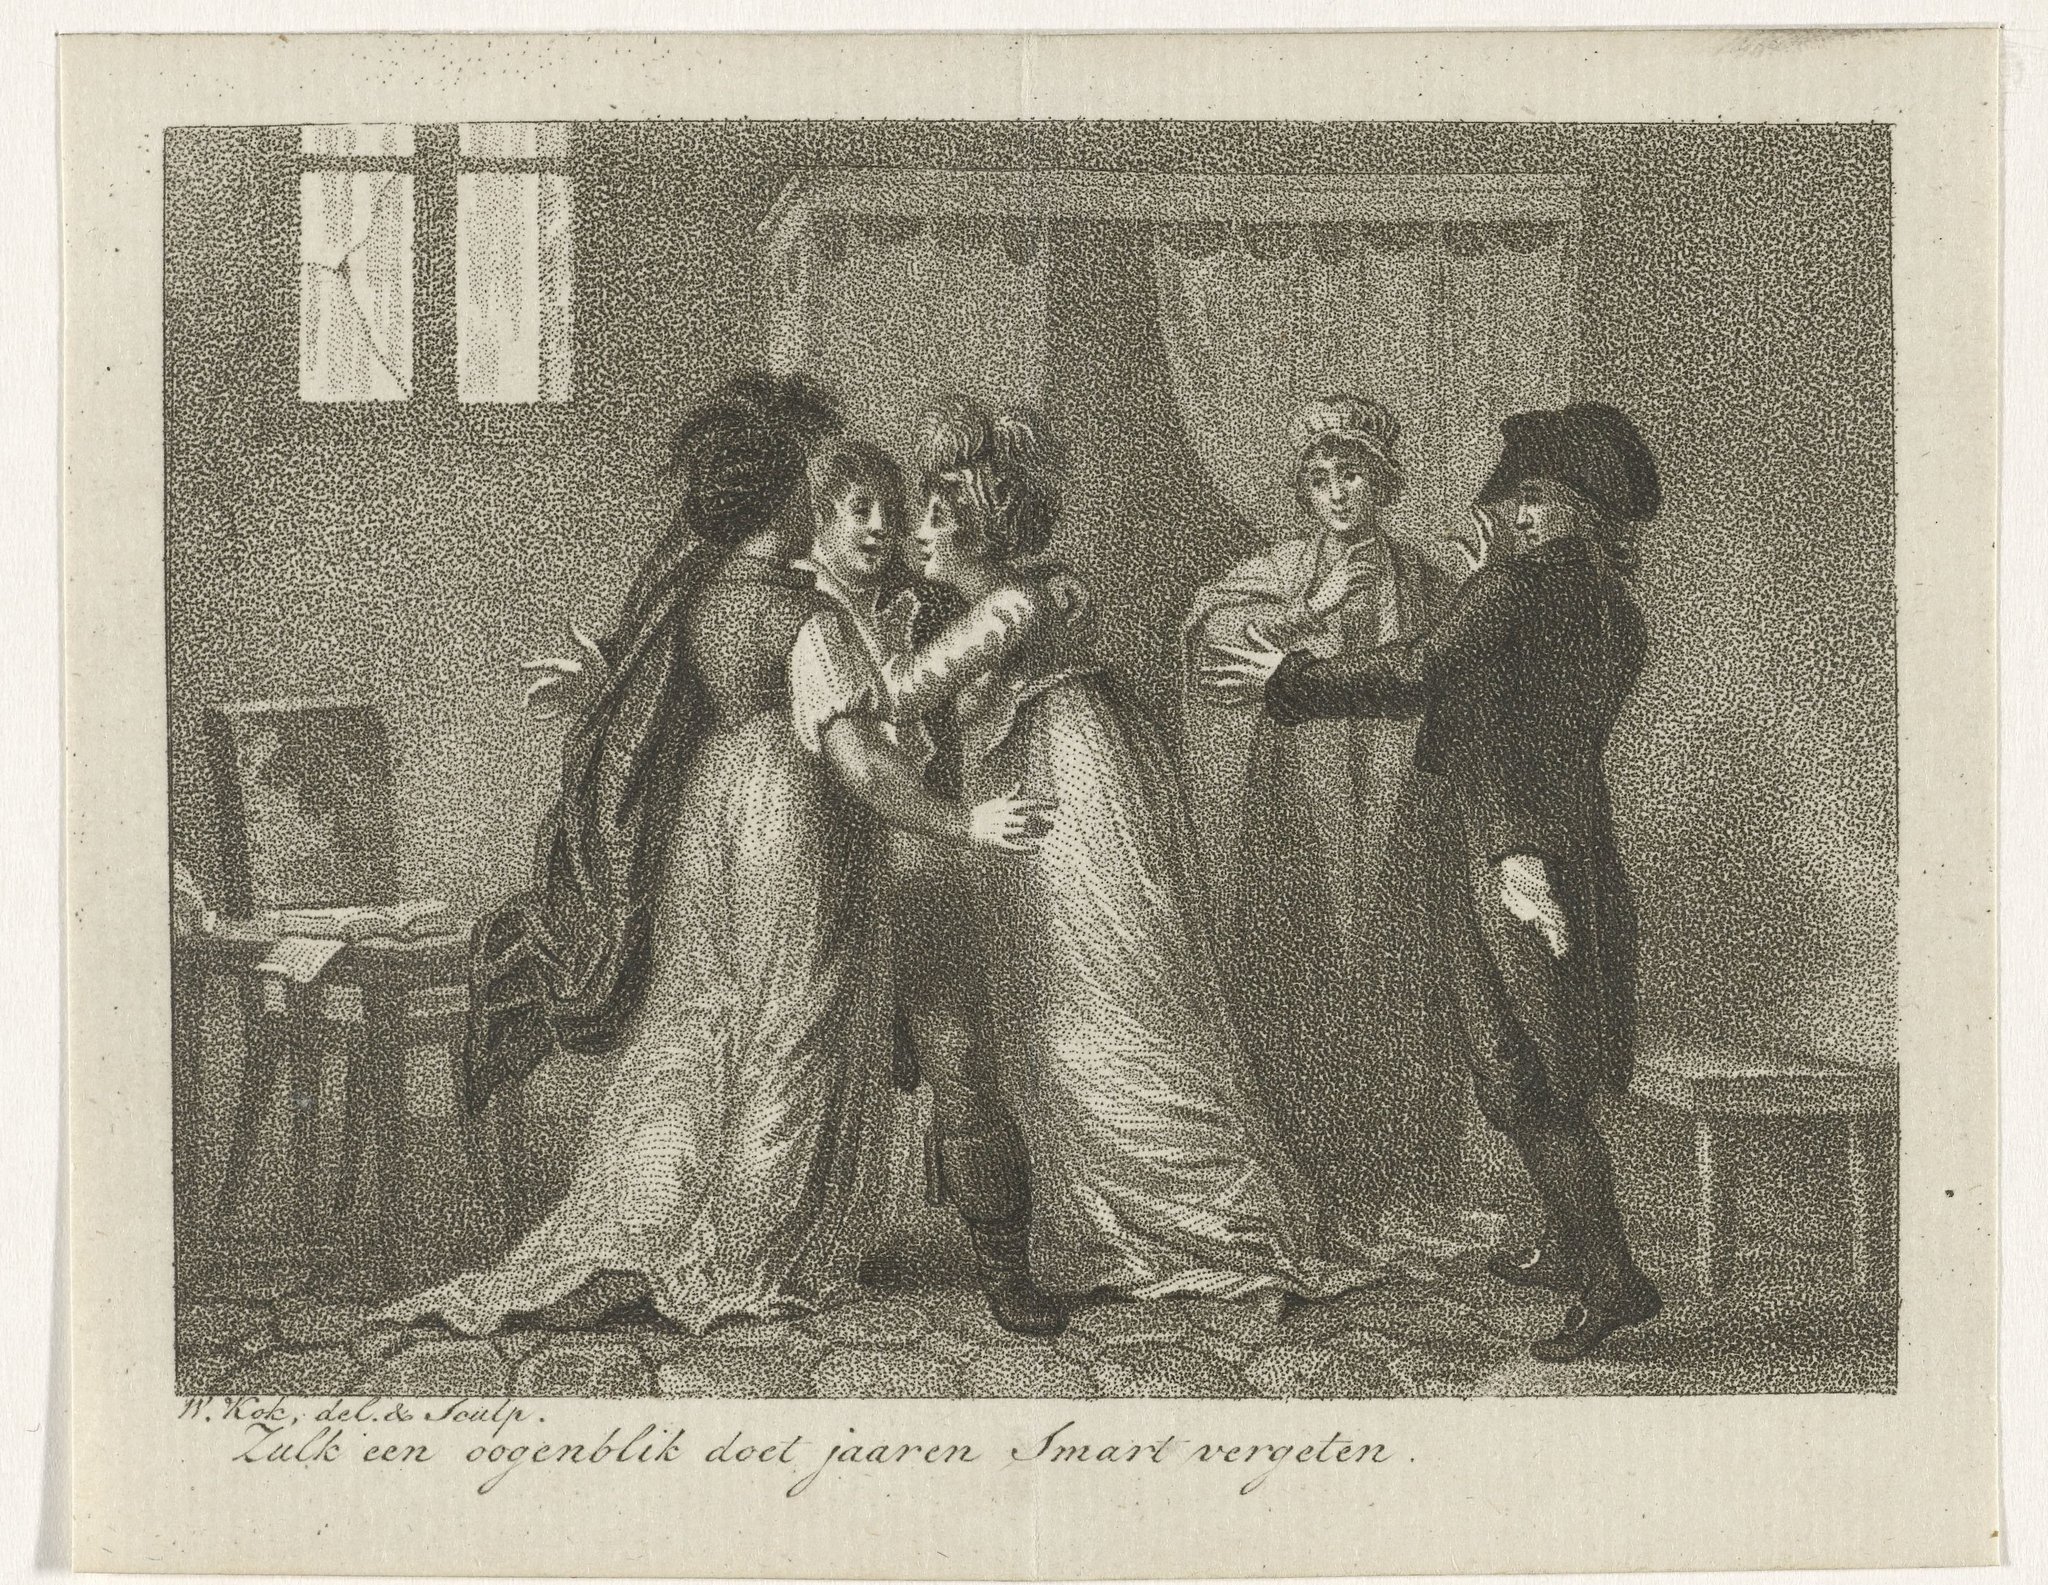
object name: print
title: Verwelkoming van soldaten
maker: willem kok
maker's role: draughtsman, print maker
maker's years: 1761-1807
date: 1803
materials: paper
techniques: engraving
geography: amsterdam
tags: being welcomed ~ travelling, the soldier; the soldier's life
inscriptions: collector's mark: Lugt 2228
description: In een sober interieur begroeten drie vrouwen en twee mannen, waarschijnlijk soldaten, elkaar. Een van de mannen draagt een uniform en de vrouwen dragen lange japonnen. In de kamer staat een tafel met boeken en in een van de ruiten zit een barst.